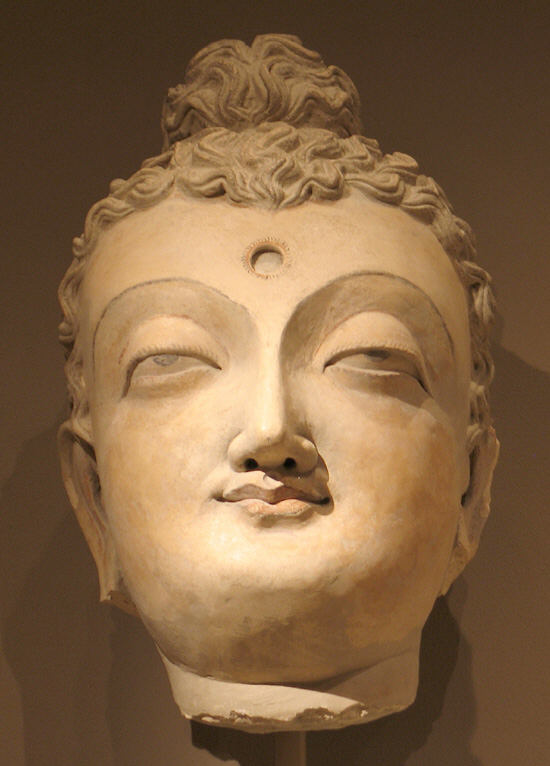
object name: head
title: Head of a Buddha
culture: gandhara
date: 301-400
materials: plaster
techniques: polychrome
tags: faces,heads,buddha